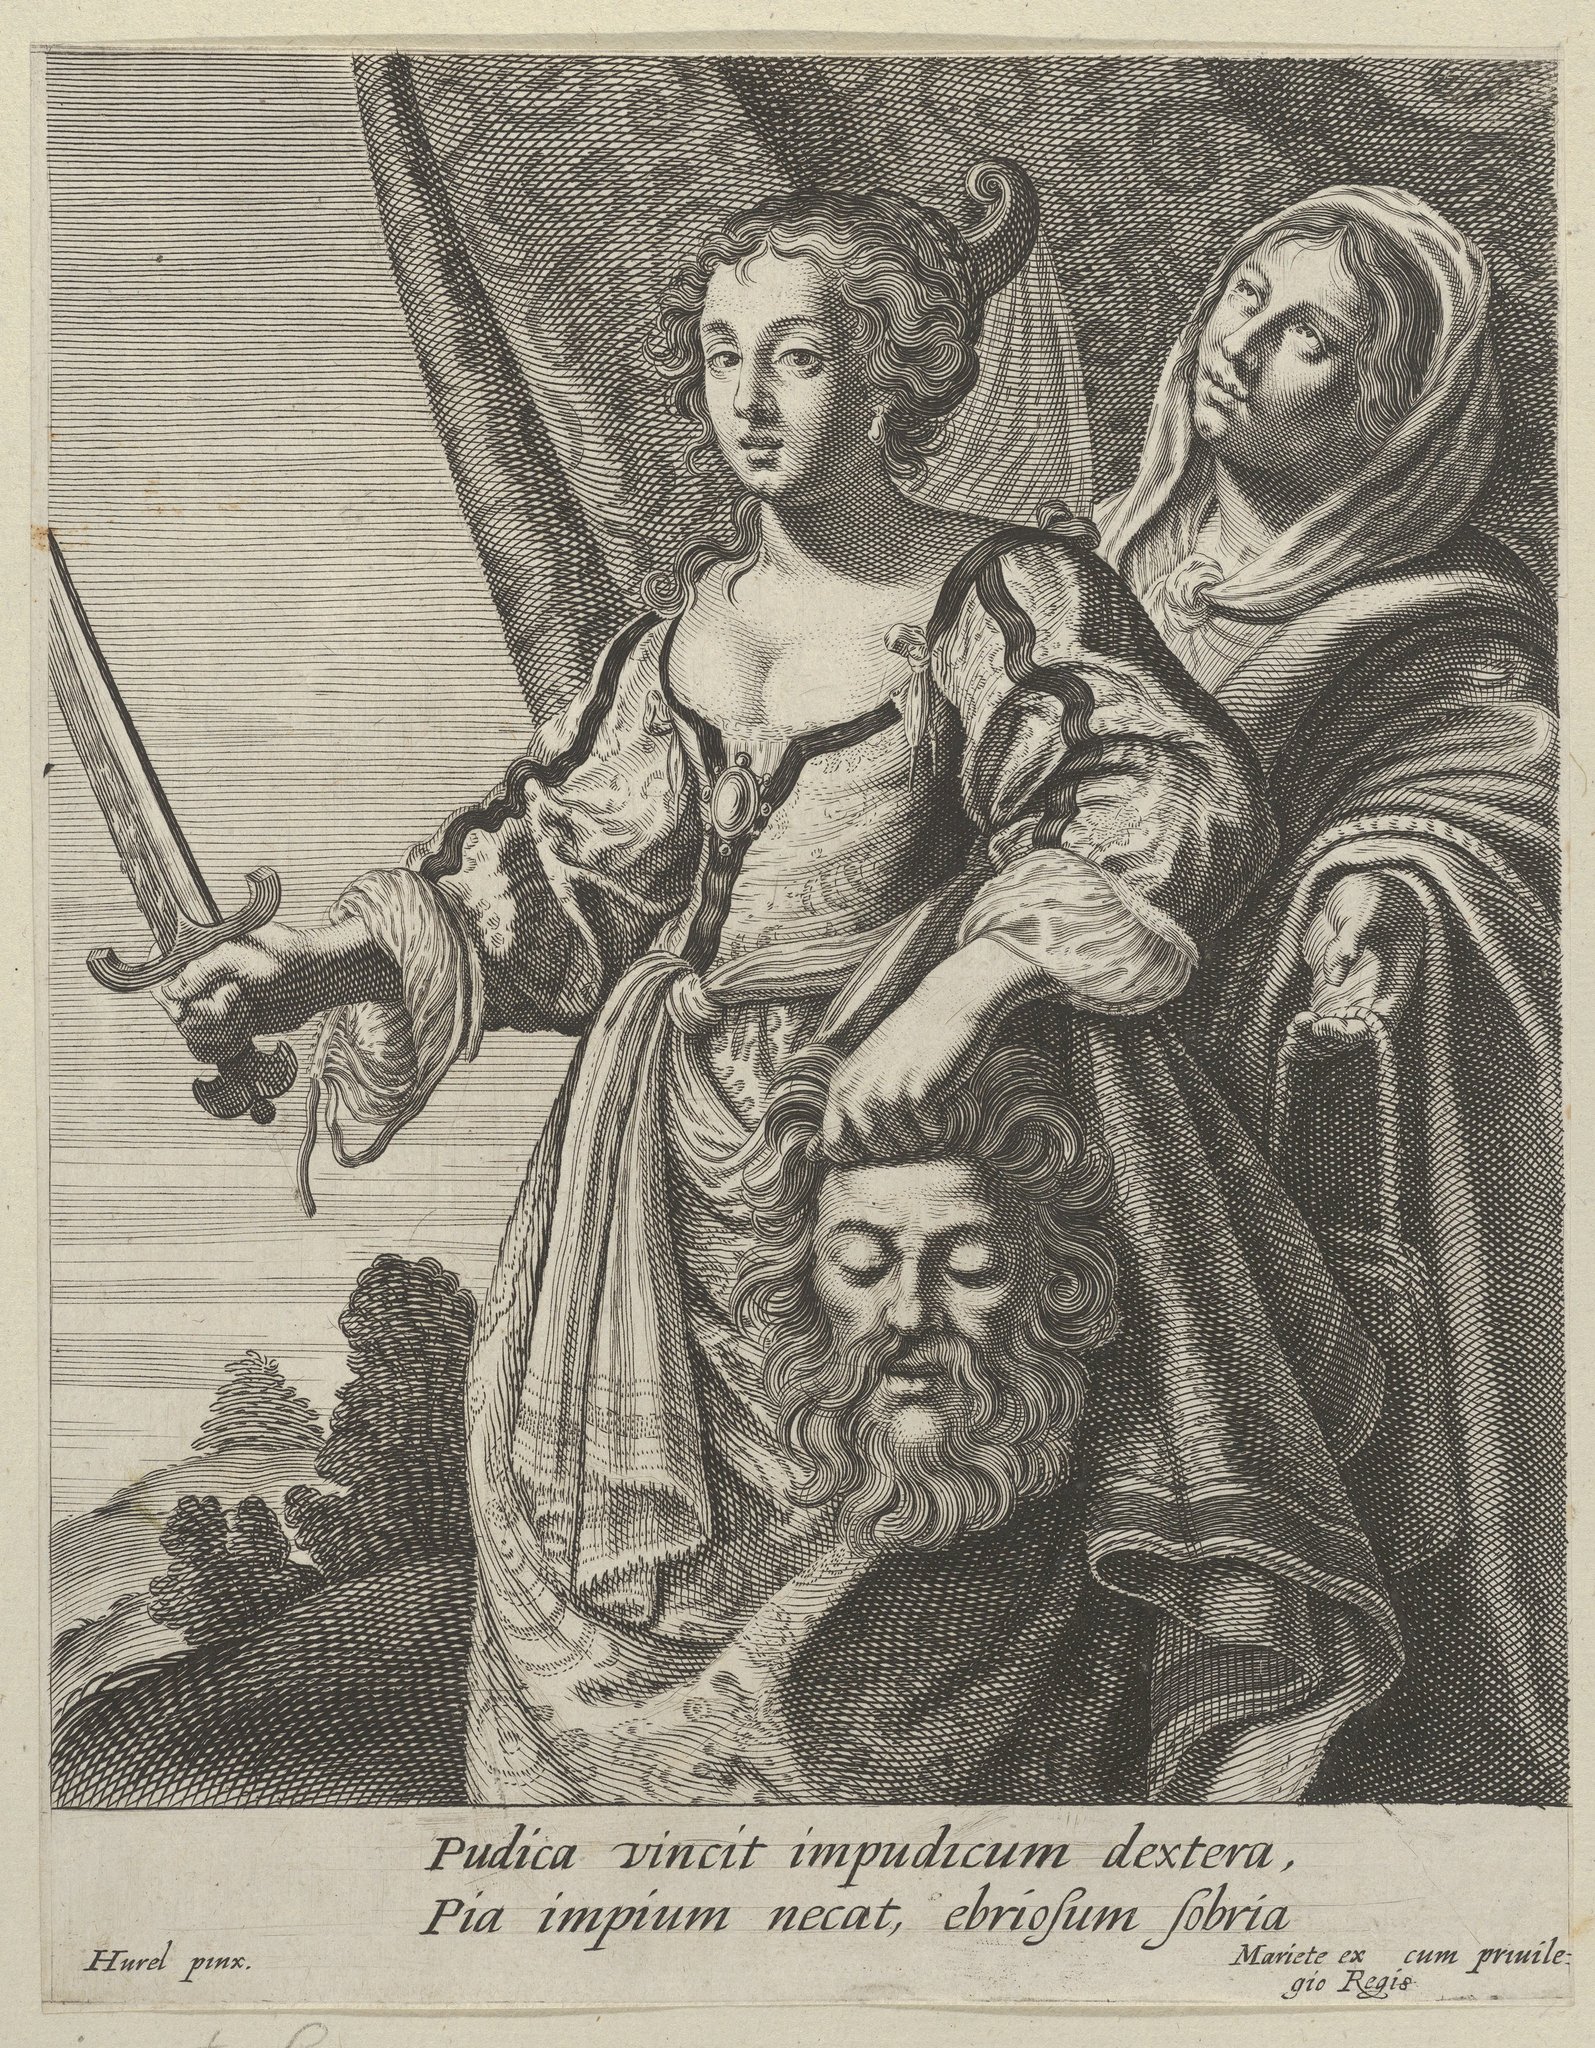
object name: print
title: Judith with the Head of Holofernes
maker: grégoire huret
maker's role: artist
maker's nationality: french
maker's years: 1606-1670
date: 1601-1700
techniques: engraving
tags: women,holofernes,judith